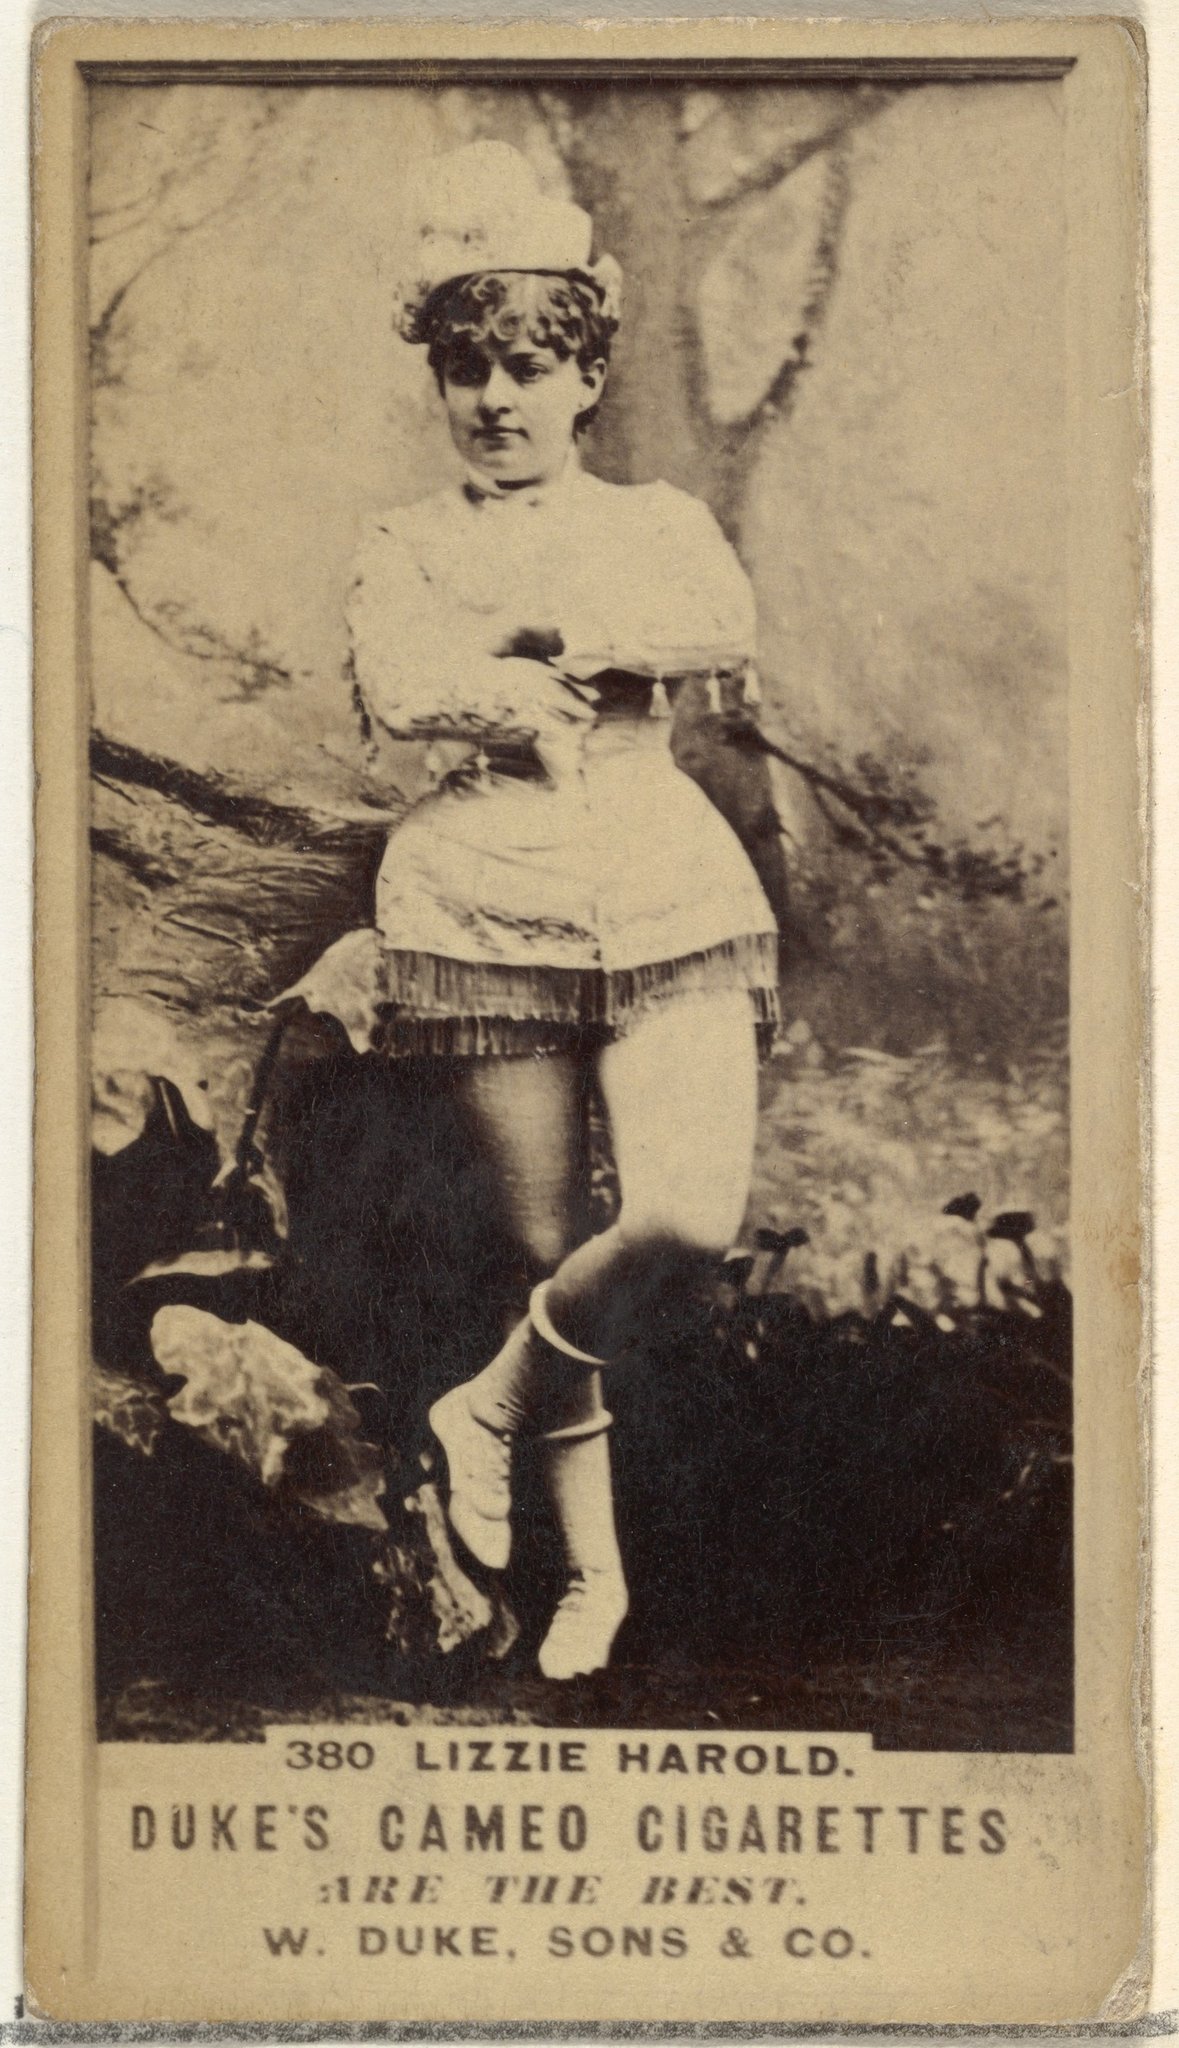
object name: photograph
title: Card Number 380, Lizzie Harold, from the Actors and Actresses series (N145-5) issued by Duke Sons & Co. to promote Cameo Cigarettes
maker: w. duke, sons & co.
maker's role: publisher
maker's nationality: american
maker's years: 1870-1920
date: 1880-1889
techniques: albumen silver print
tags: portraits,women,actresses